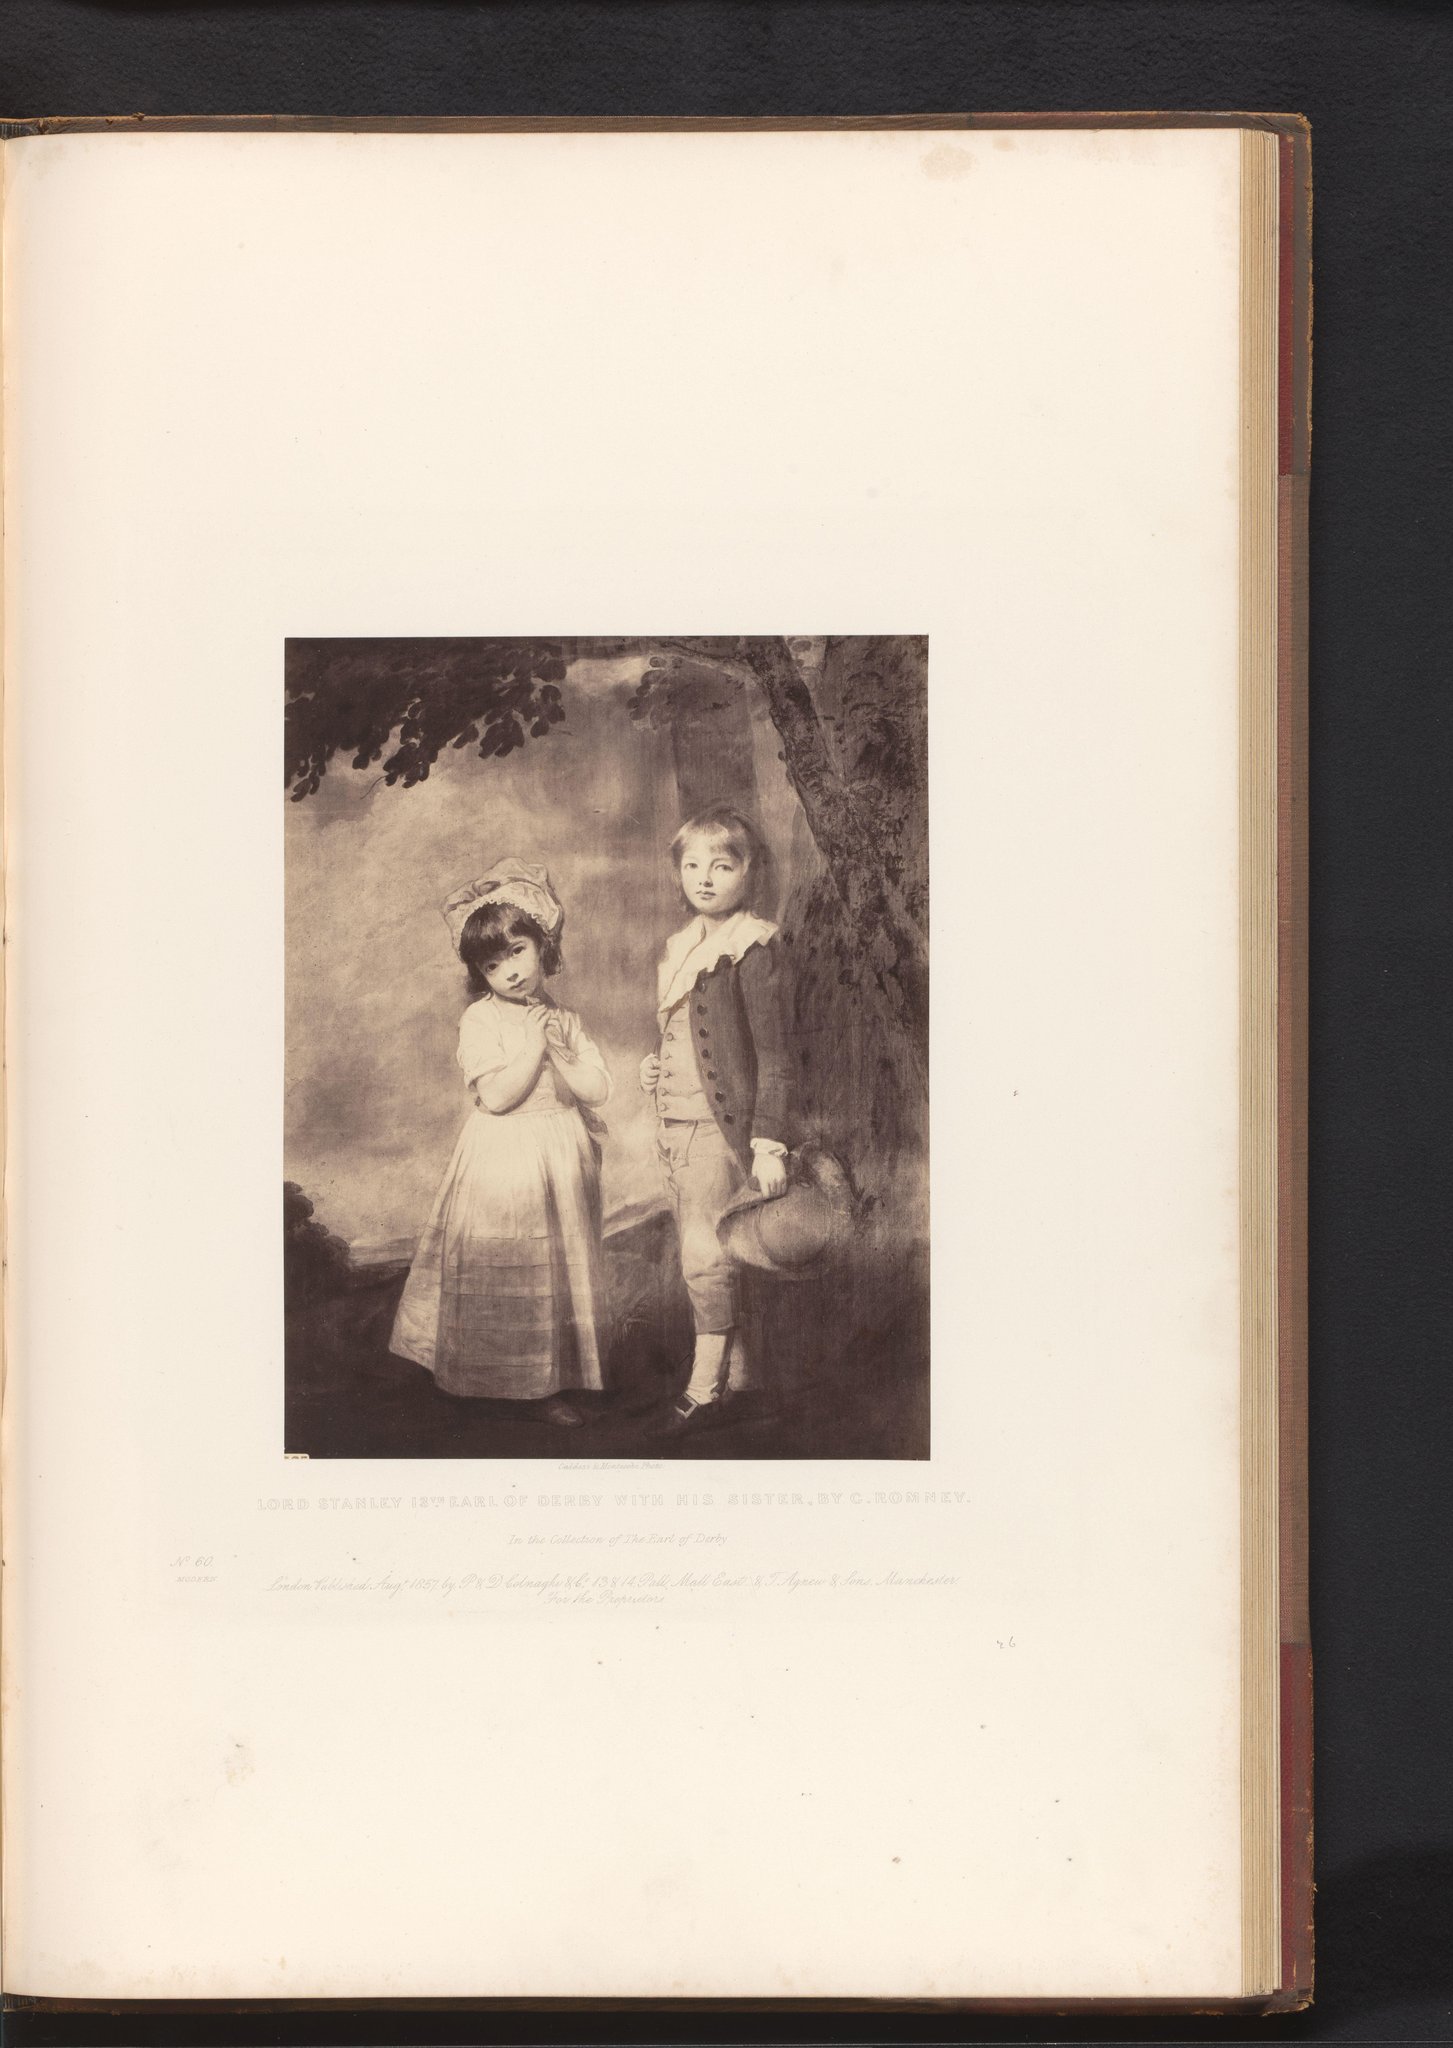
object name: page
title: Lord Stanley 13th Earl of Derby with his Sister, by G. Romney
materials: photographic support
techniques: albumen print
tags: london, earl, boy (child between toddler and youth), historical persons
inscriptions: number: ‘26’, inscription: ‘In the Collection of The Earl of Derby./ London, Published Augt, 1857, by P. & D. Colnaghi & Co, 13 & 14, Pall Mall East & T. Agneur & Sons, Manchester./ For the Proprietors.’, number: ‘No. 60./ MODERN.’